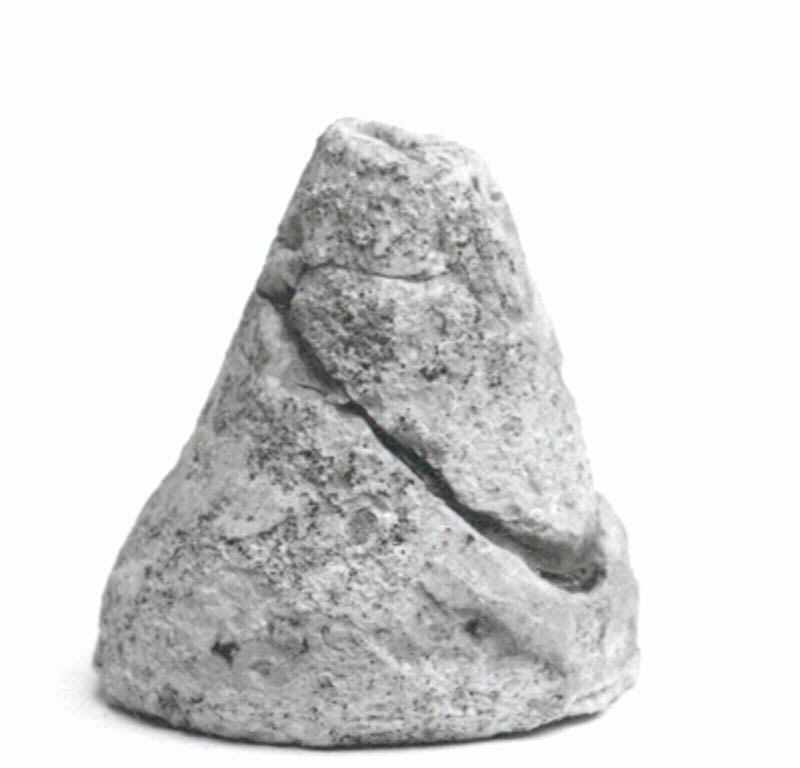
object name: pendant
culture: sasanian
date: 201-700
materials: glass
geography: mesopotamia